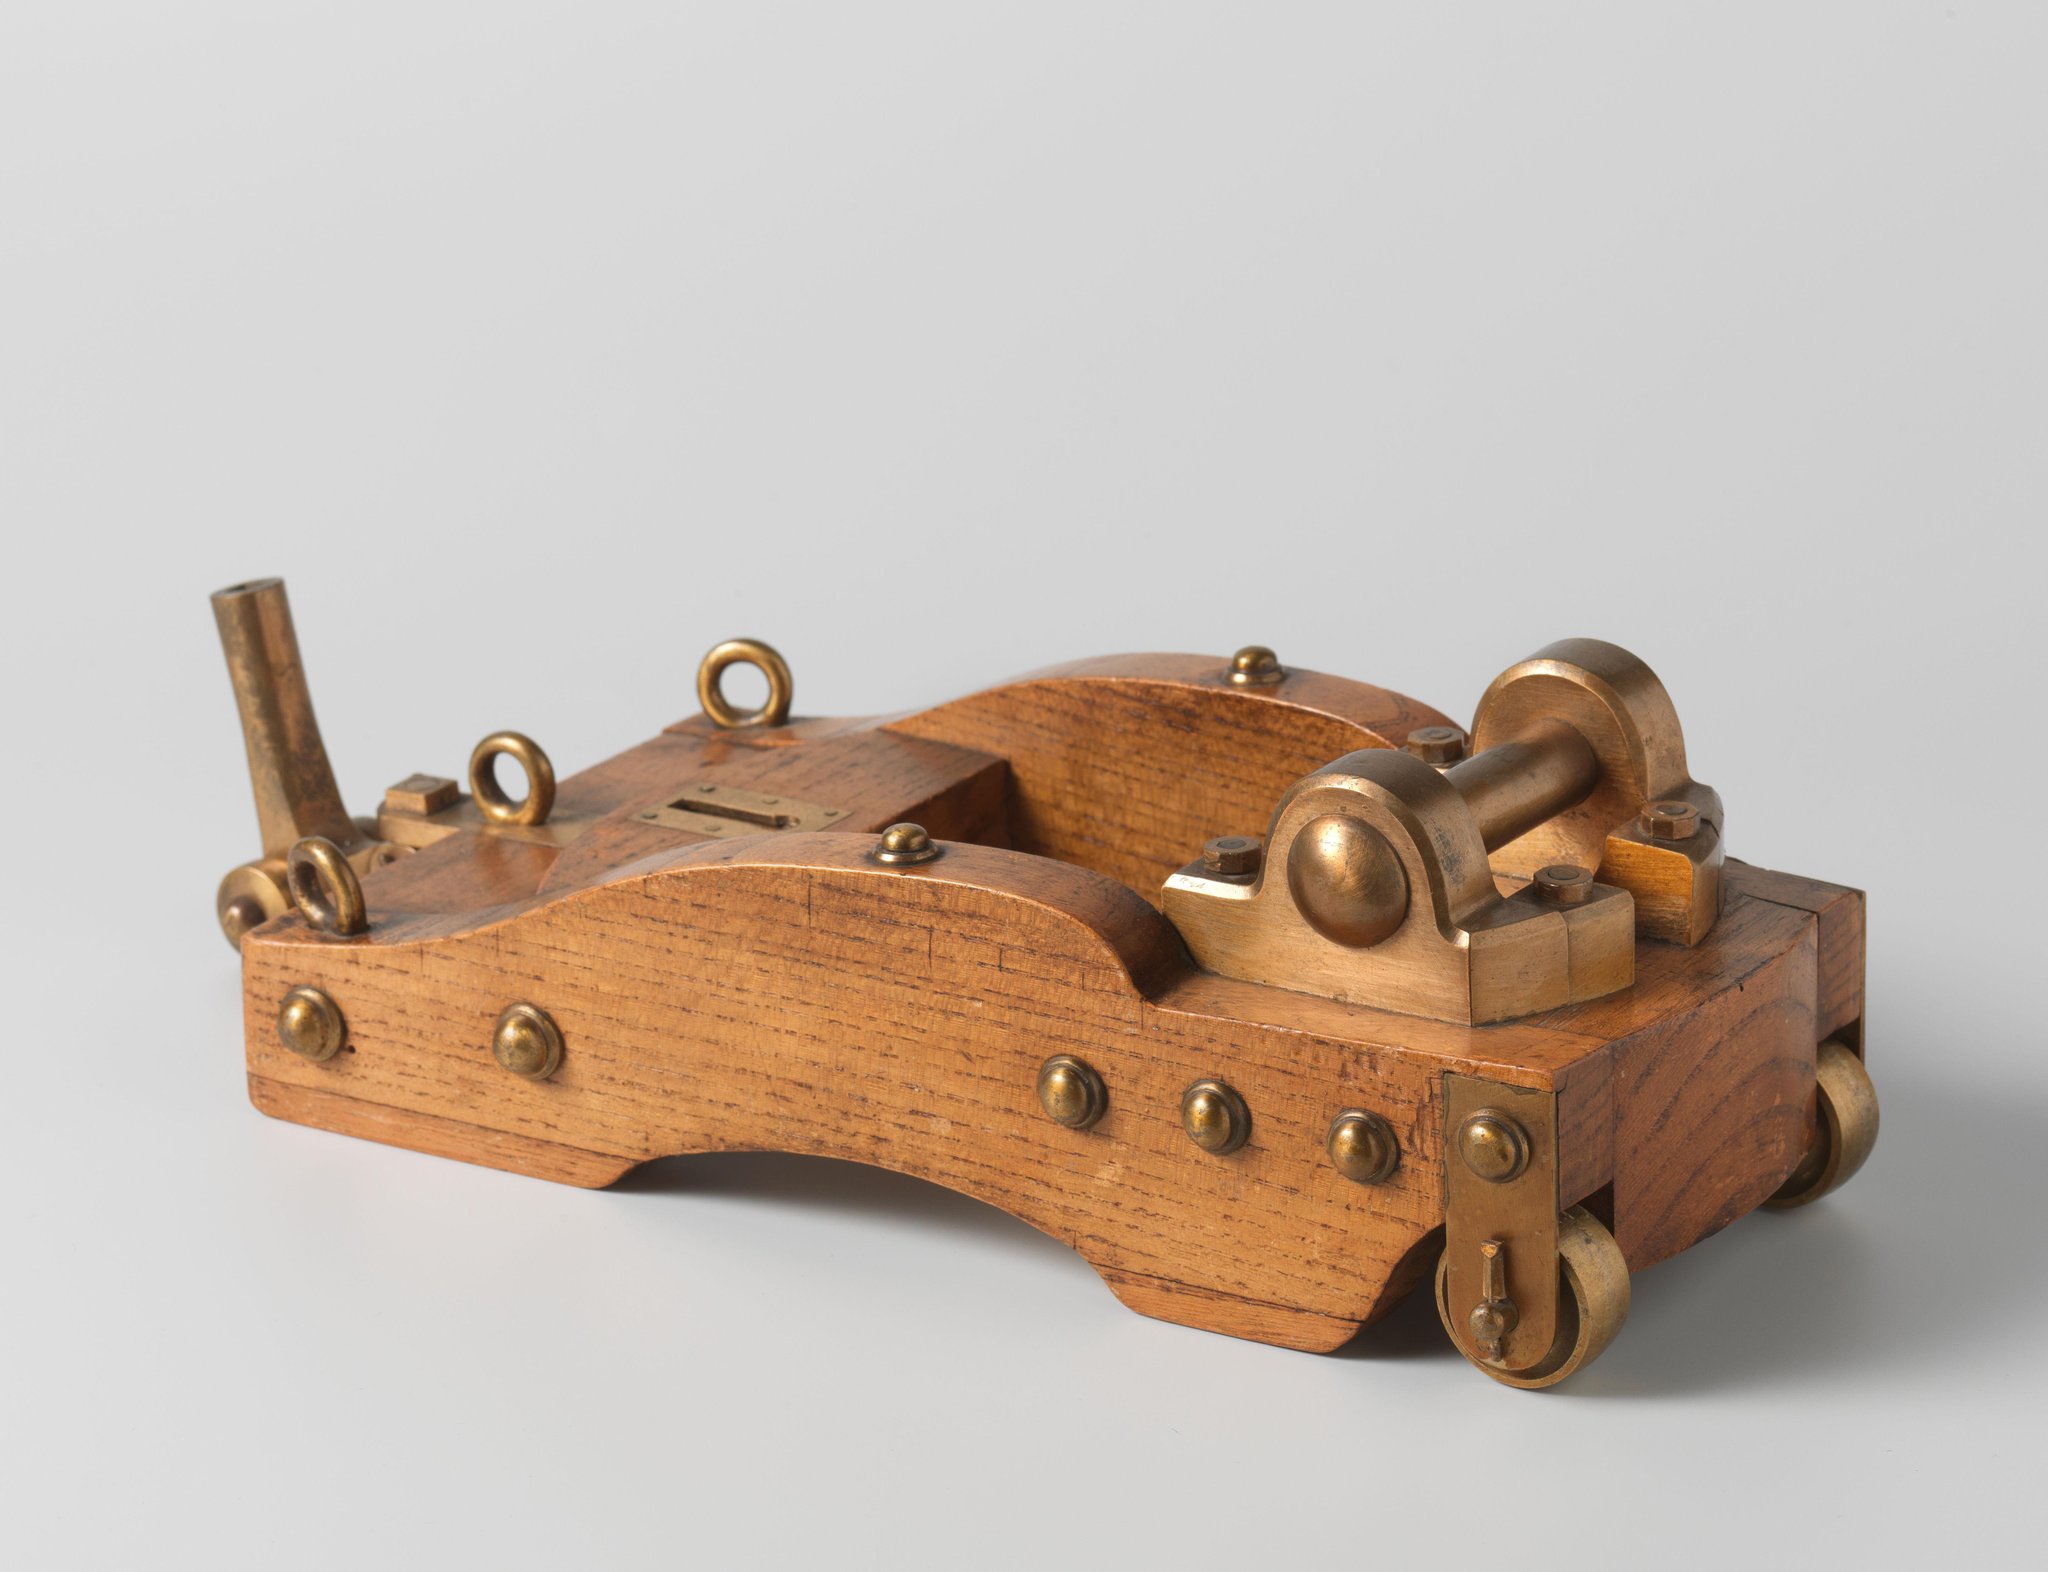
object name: demonstration model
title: Model of a Carriage for a 36-Pounder Carronade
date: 1839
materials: brass, wood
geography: amsterdam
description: Model van een schuifaffuit voor een carronade van 30 pond. Het naar voren toelopende lichaam bestaat uit twee wangen met beslag en ringen, met daartussen twee zeer zware houten blokken. De wangen hebben een gebogen bovenkant en een ellipsvormige uitsnede beneden. Bovenop het voorste tussenblok zijn de oren met tapas aangebracht, op het achterste beslag met het spoor voor de eleveerschroef. Het affuit rust op wrijvingsklossen onder de wangen, om het recuul te beperken. Twee kleine rollers op een scharnier tegen de achterzijde kunnen met behulp van het baksijzer de achterkant van het affuit opkrikken; het affuit rust dan voor ook op twee rollers, die voor de voorste dwarsbalk zijn aangebracht, en is zo gemakkelijk te boord te rollen. Schaal 1:5 (Obreen).